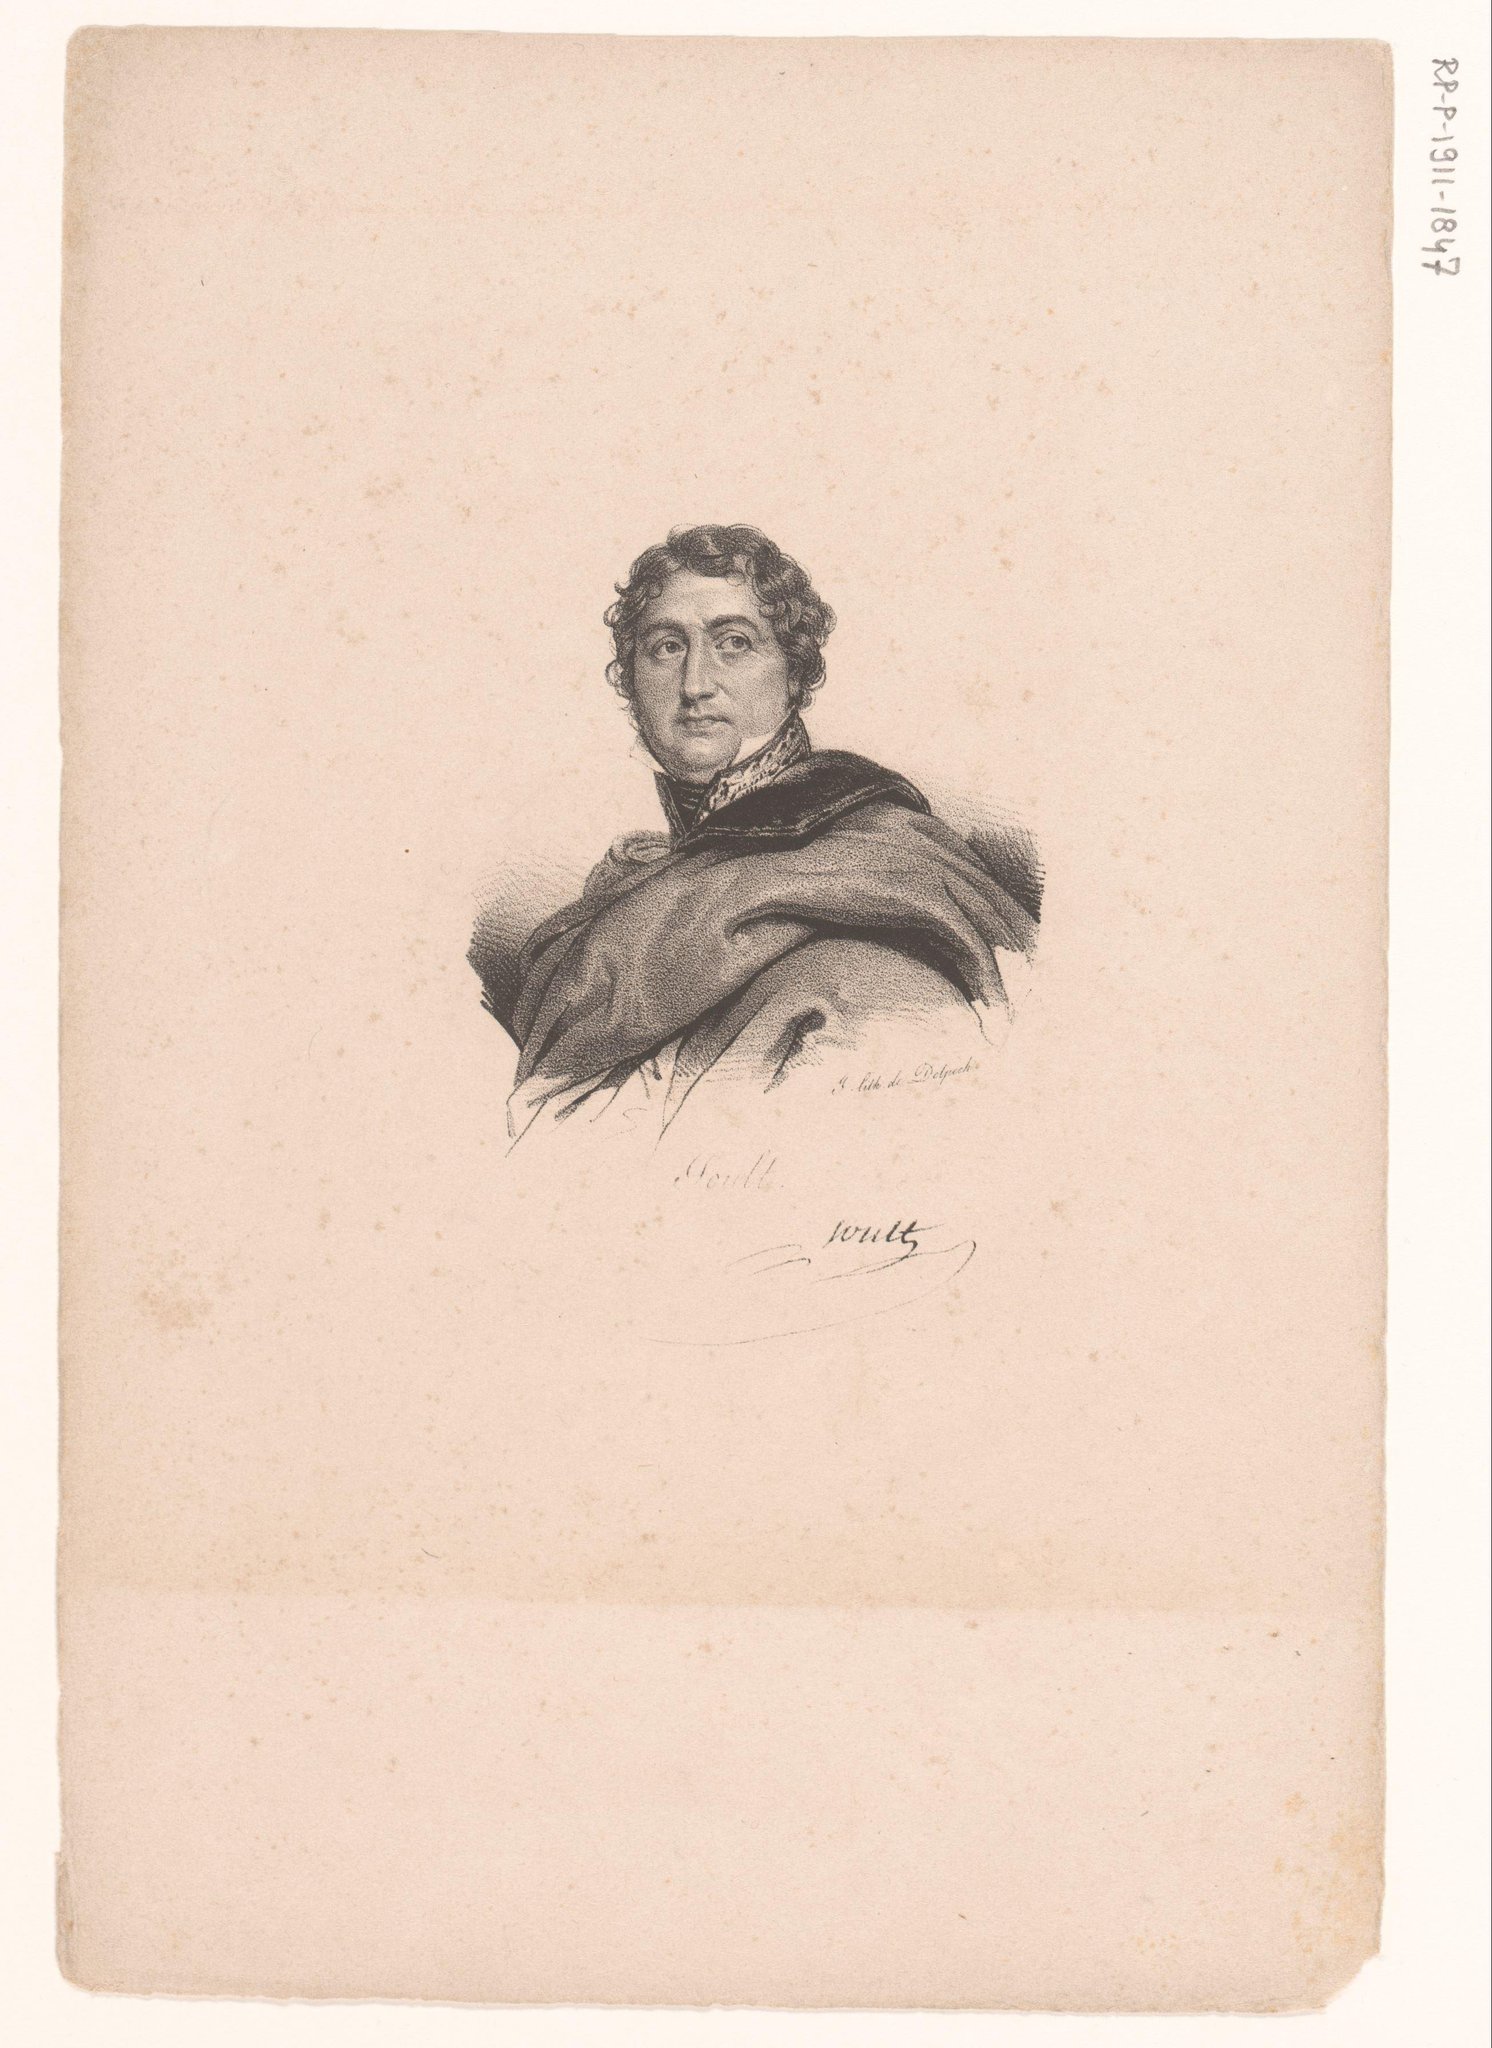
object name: print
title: Soult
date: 1818-1842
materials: paper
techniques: lithograph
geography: paris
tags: historical persons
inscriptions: collector's mark: Lugt 2228a